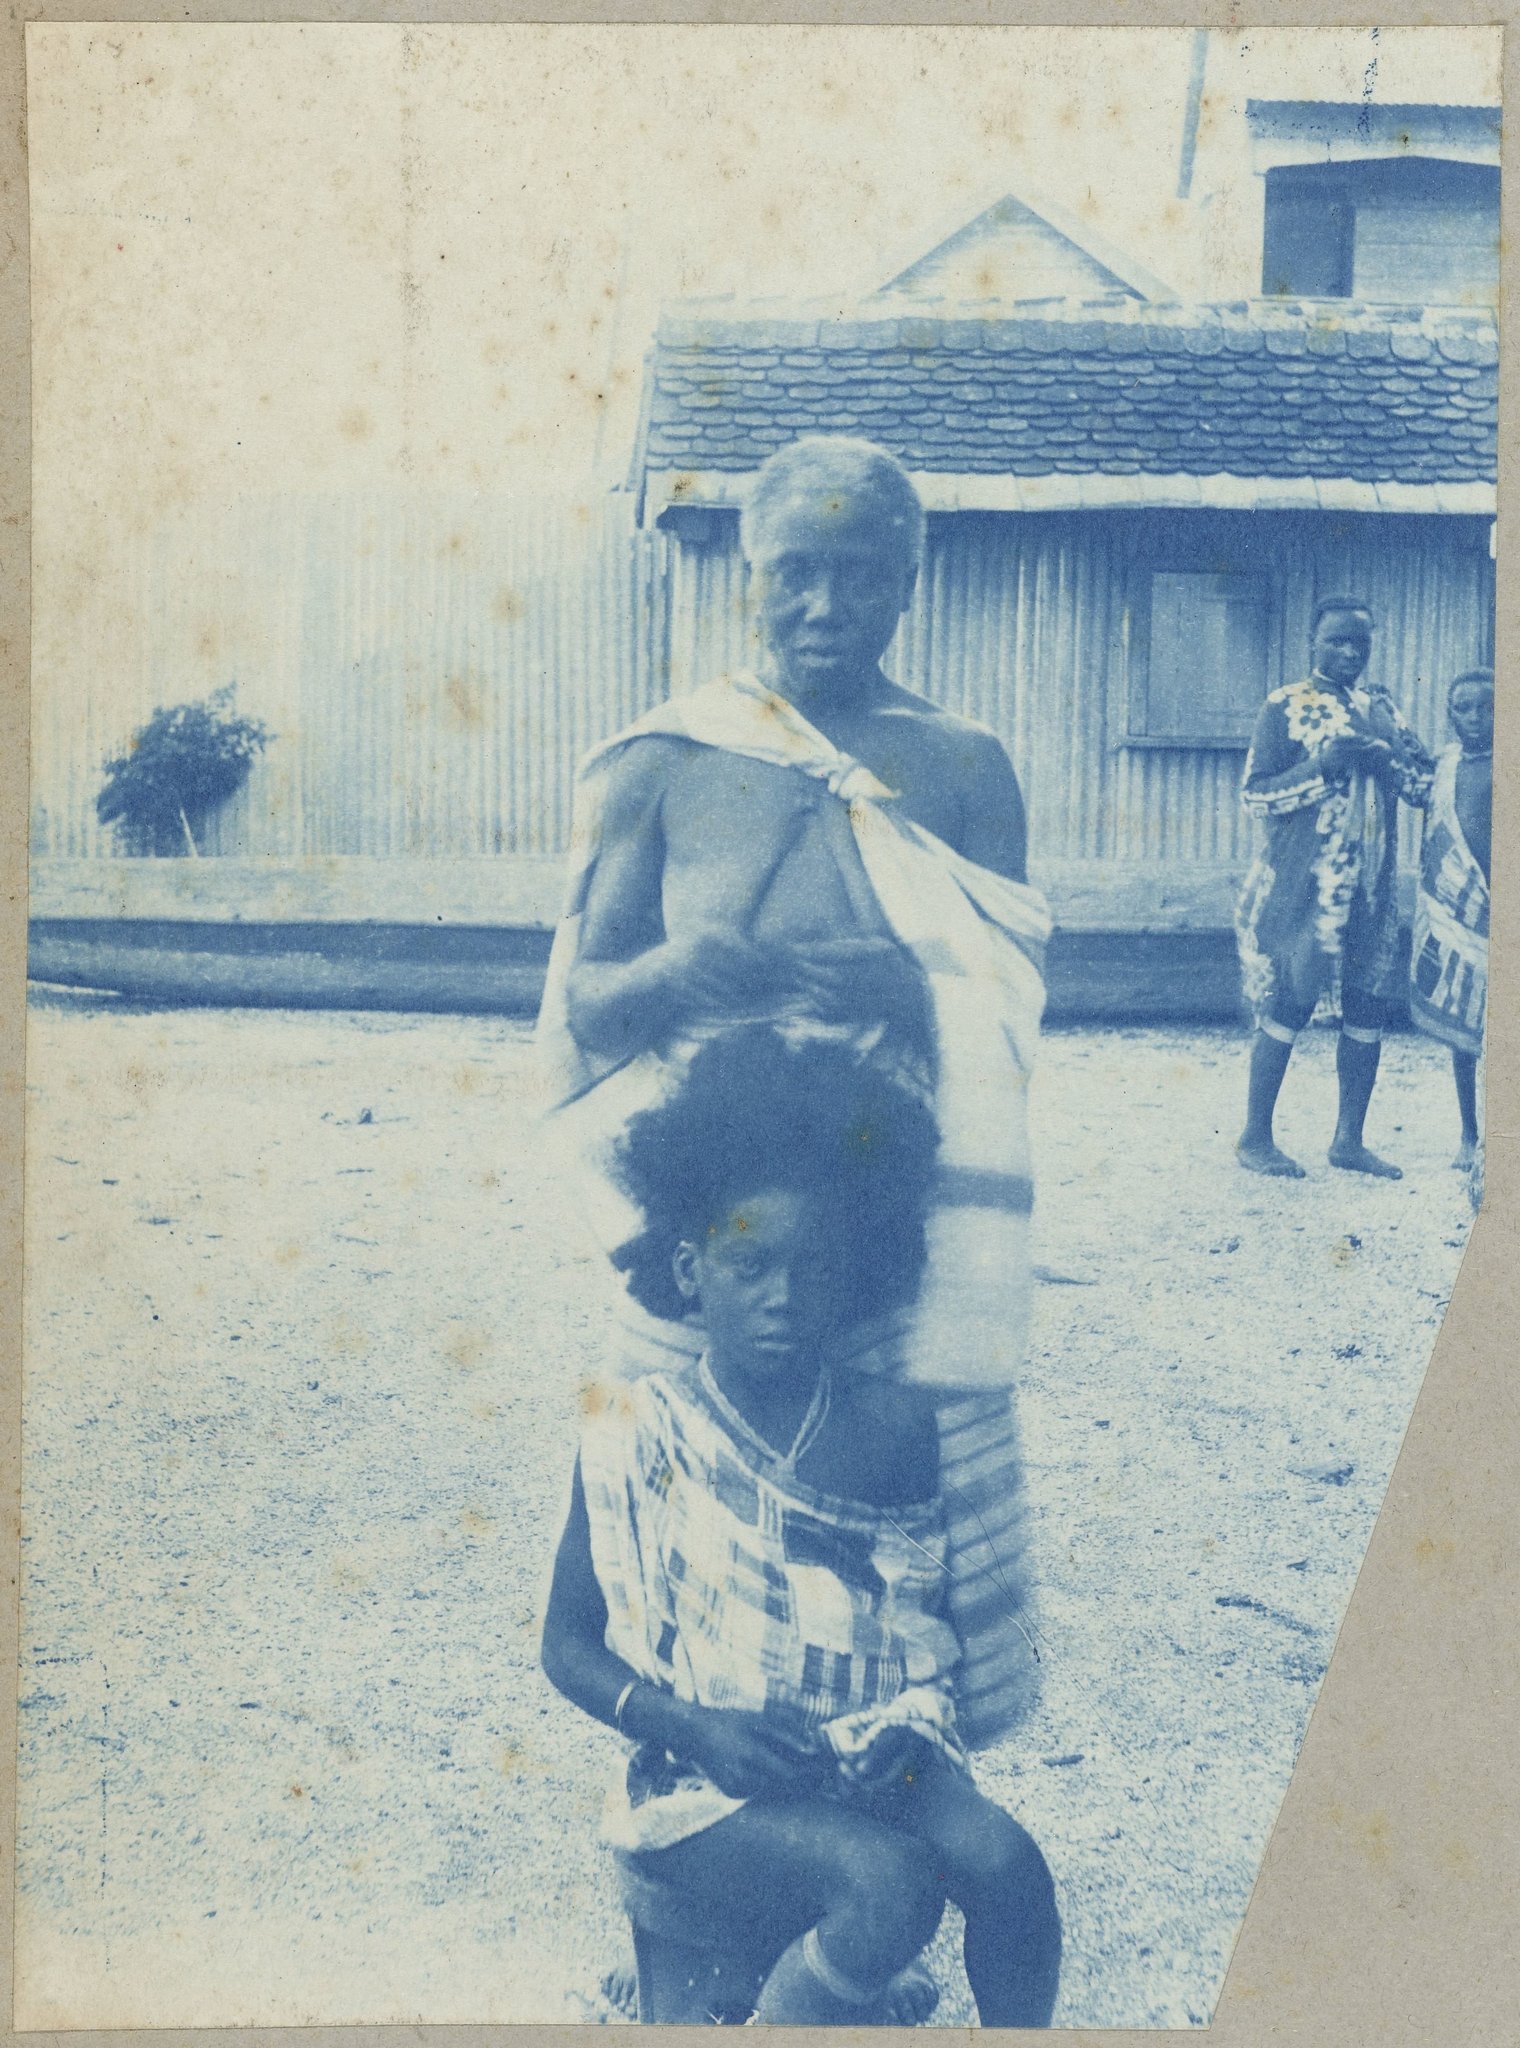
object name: photograph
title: Coiffure van een boschnegerinnetje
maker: hendrik doijer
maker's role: engineer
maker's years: 1863-1925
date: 1903-1910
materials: photographic support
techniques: cyanotype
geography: suriname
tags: suriname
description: Zittend Marronmeisje met een oudere Marronvrouw. Onderdeel van het fotoalbum Souvenir de Voyage (deel 1), over het leven van de familie Doijer in en rond de plantage Ma Retraite in Suriname in de jaren 1903-1910.